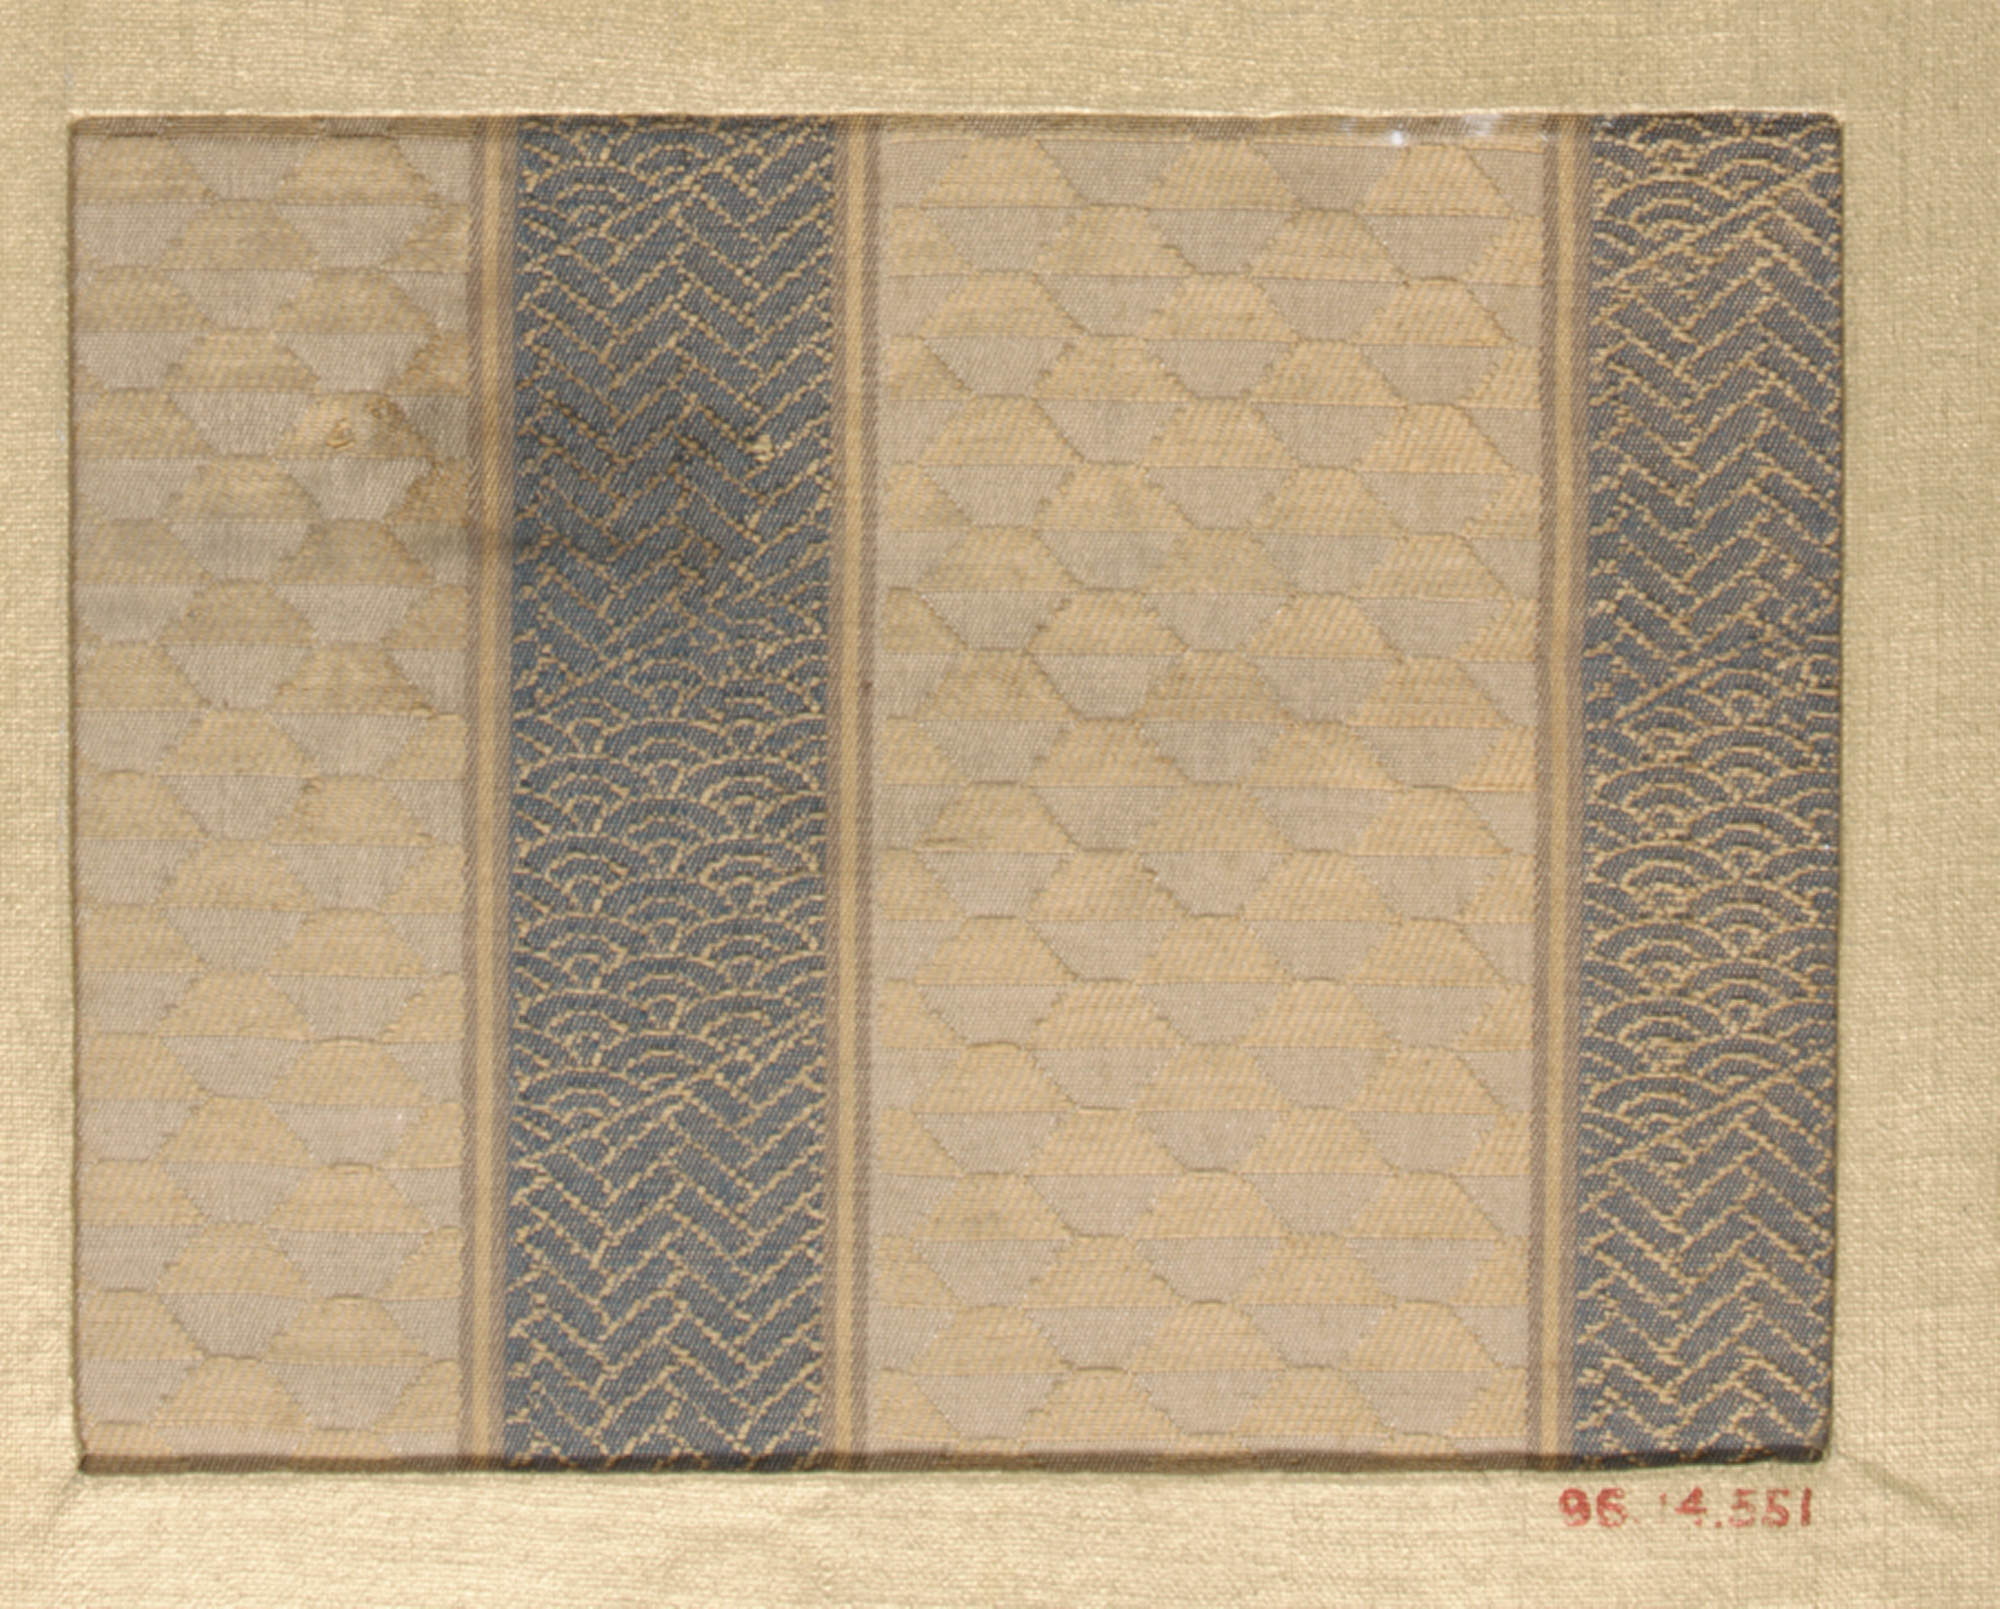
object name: piece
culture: japanese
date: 1701-1900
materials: silk